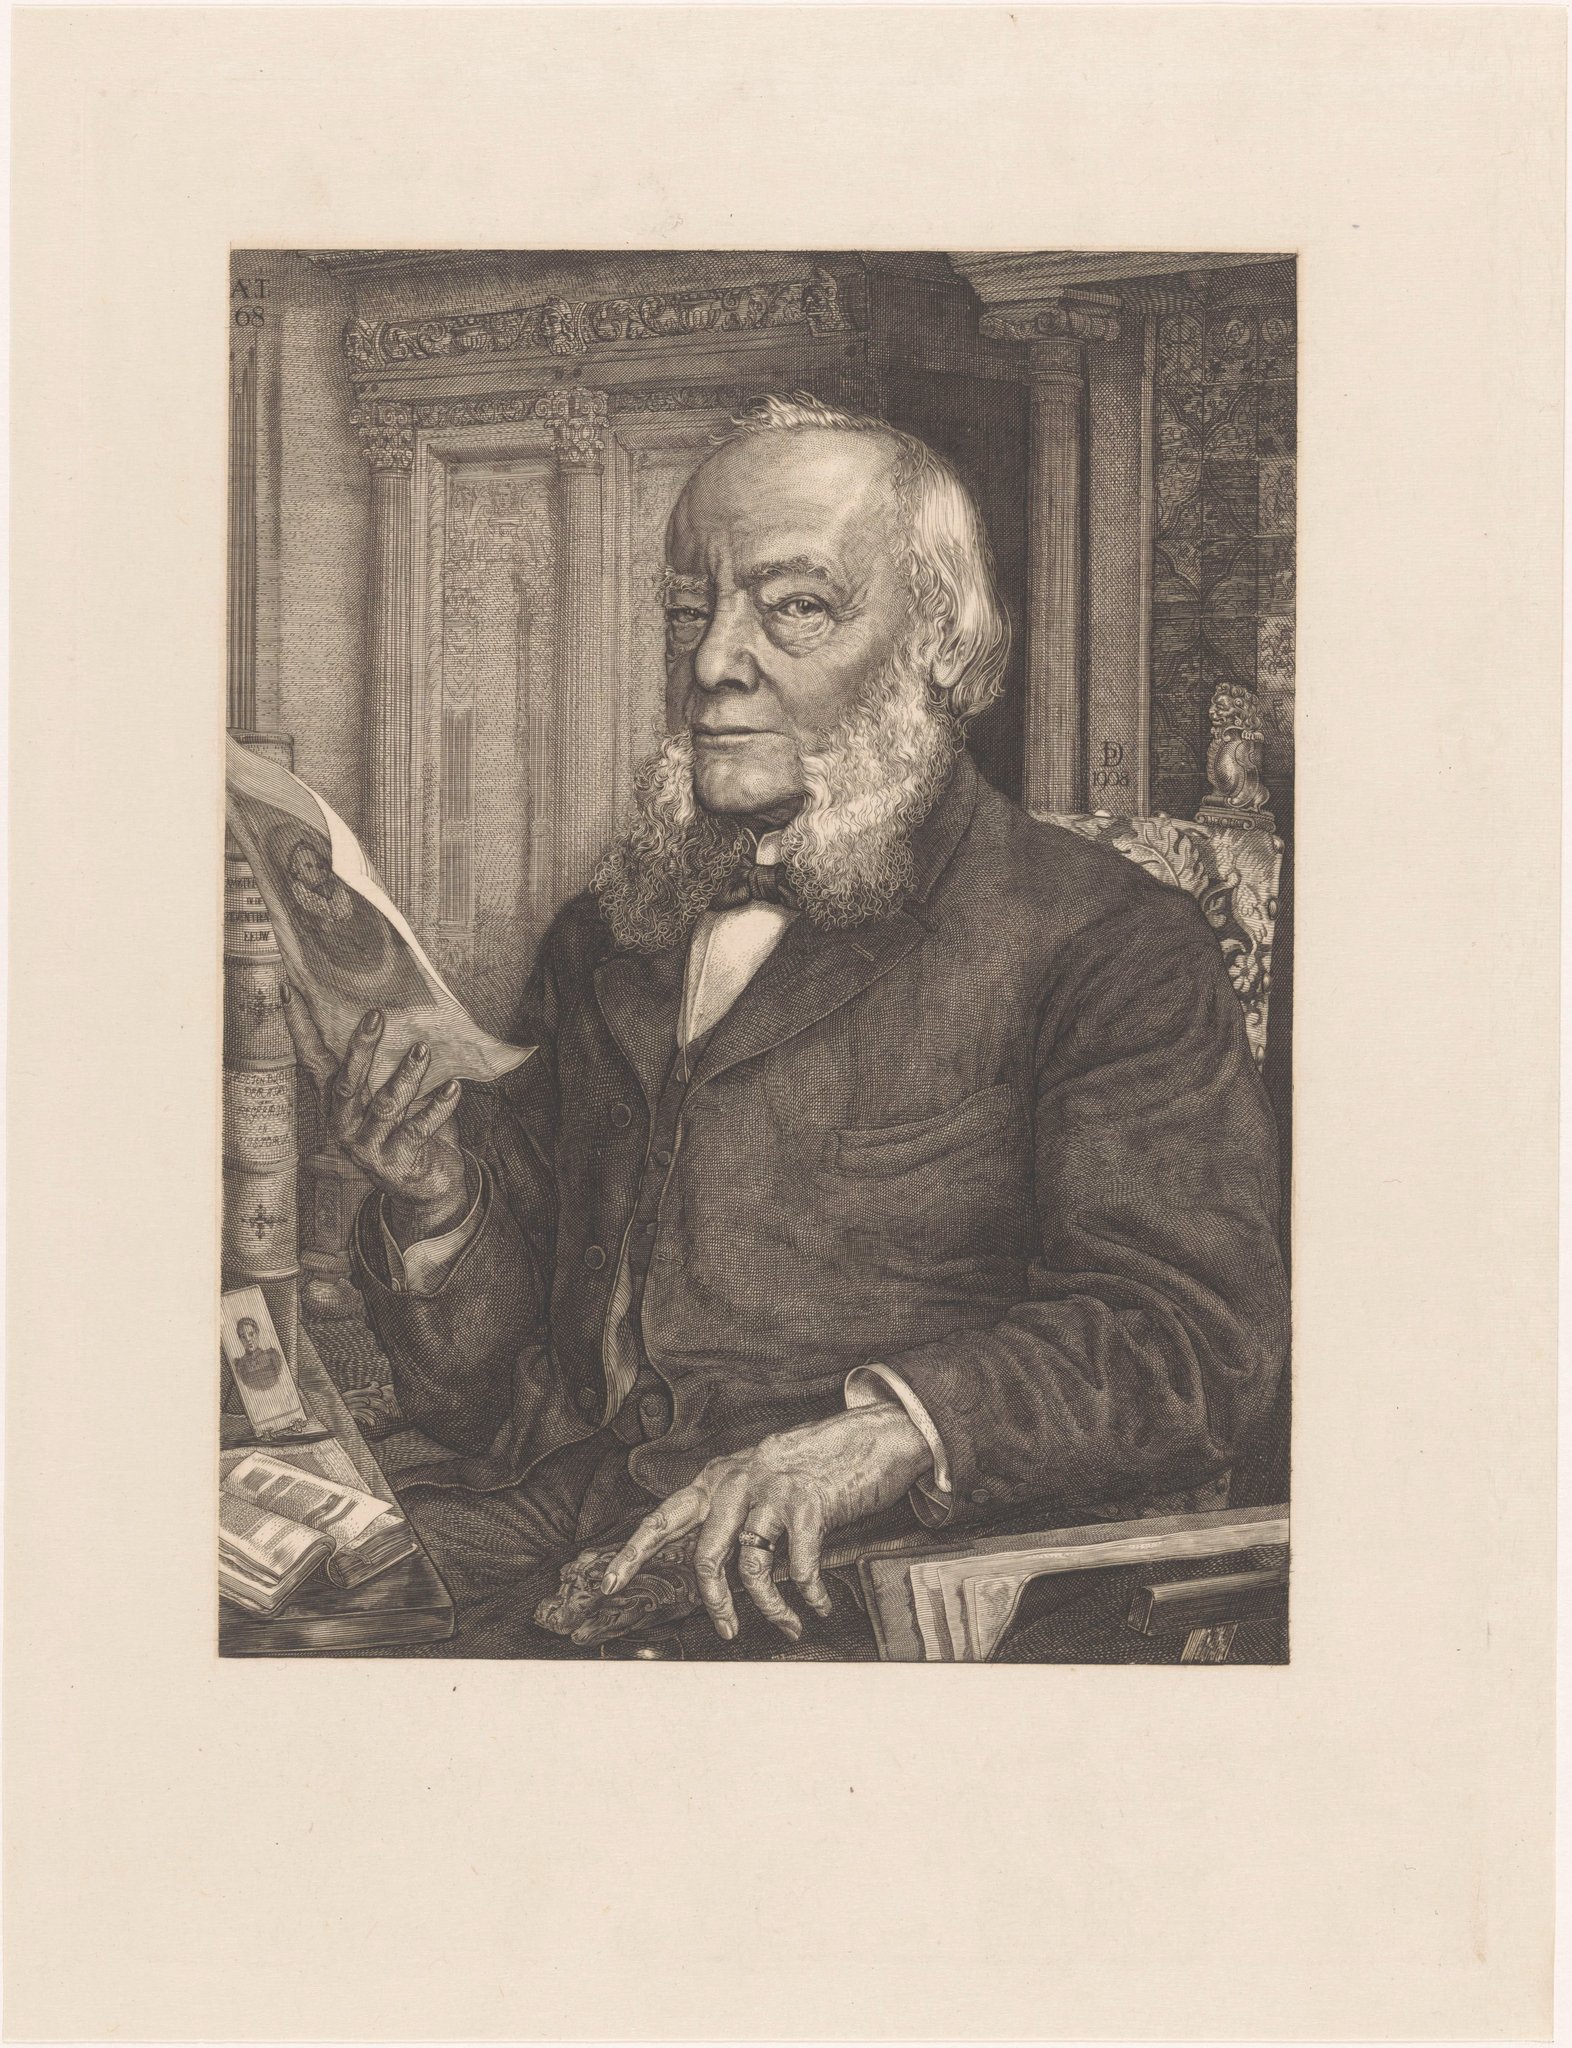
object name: print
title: Portret van Dirk Christiaan Meijer jr.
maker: pieter dupont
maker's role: draughtsman, print maker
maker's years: 1870-1911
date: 1908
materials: paper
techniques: engraving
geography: hilversum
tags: amsterdam, dirk christiaan meijer jr., print, e.g.: engraving, etching, lithograph, historical persons, art collector, book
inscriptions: collector's mark: Lugt 2233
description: Portret van de oudheidkundige, wijnhandelaar en antiekverzamelaar Dirk Christiaan Meijer jr., tevens mede-oprichter van het Genootschap Amstelodamum en penningmeester van het Koninklijk Oudheidkundige Genootschap. Op deze derde staat van de prent is het interieur waarin Meijer zich bevindt voltooid. Meijer zit in een stoel met een prent in zijn rechterhand. Naast hem een map met prenten in een standaard. Op de tafel voor hem boeken en een foto in een lijst. In de achtergrond een kast en een schouw.